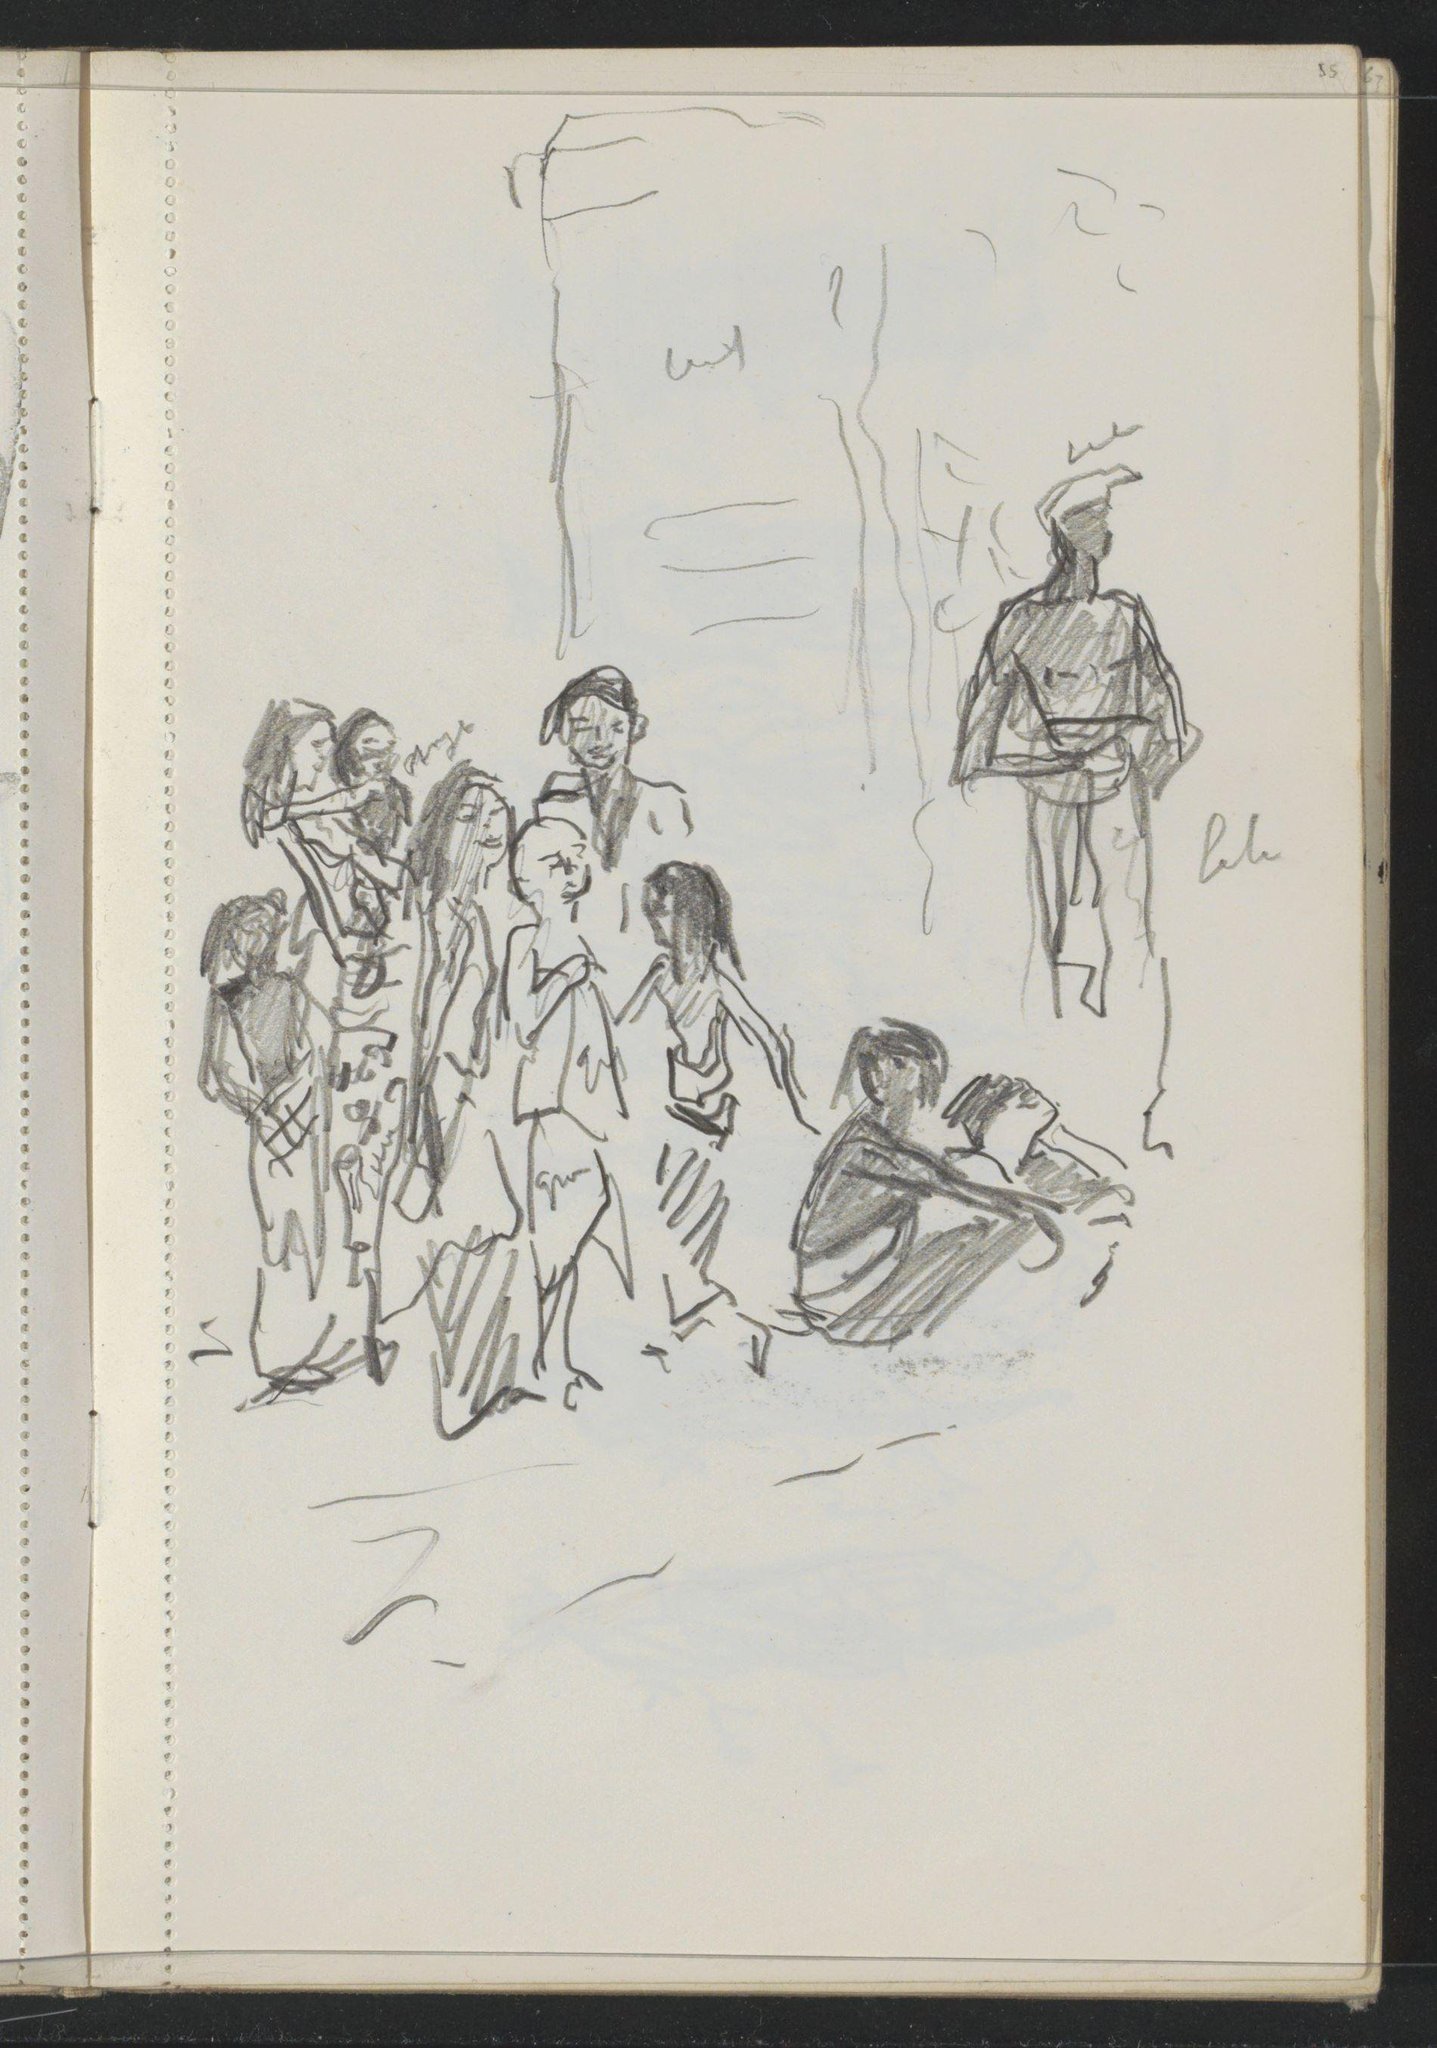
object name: sketchbook leaf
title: Straat met Indonesische kinderen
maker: marius bauer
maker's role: draughtsman, print maker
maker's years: 1867-1932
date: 1925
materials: paper, pencil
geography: indonesia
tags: asiatic races and peoples, child, street (+ city(-scape) with figures, staffage)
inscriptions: kleurnotitie, handgeschreven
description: Tussen en naast de kinderen staan ook enkele volwassenen. Pagina 55 uit een schetsboek met 74 bladen.